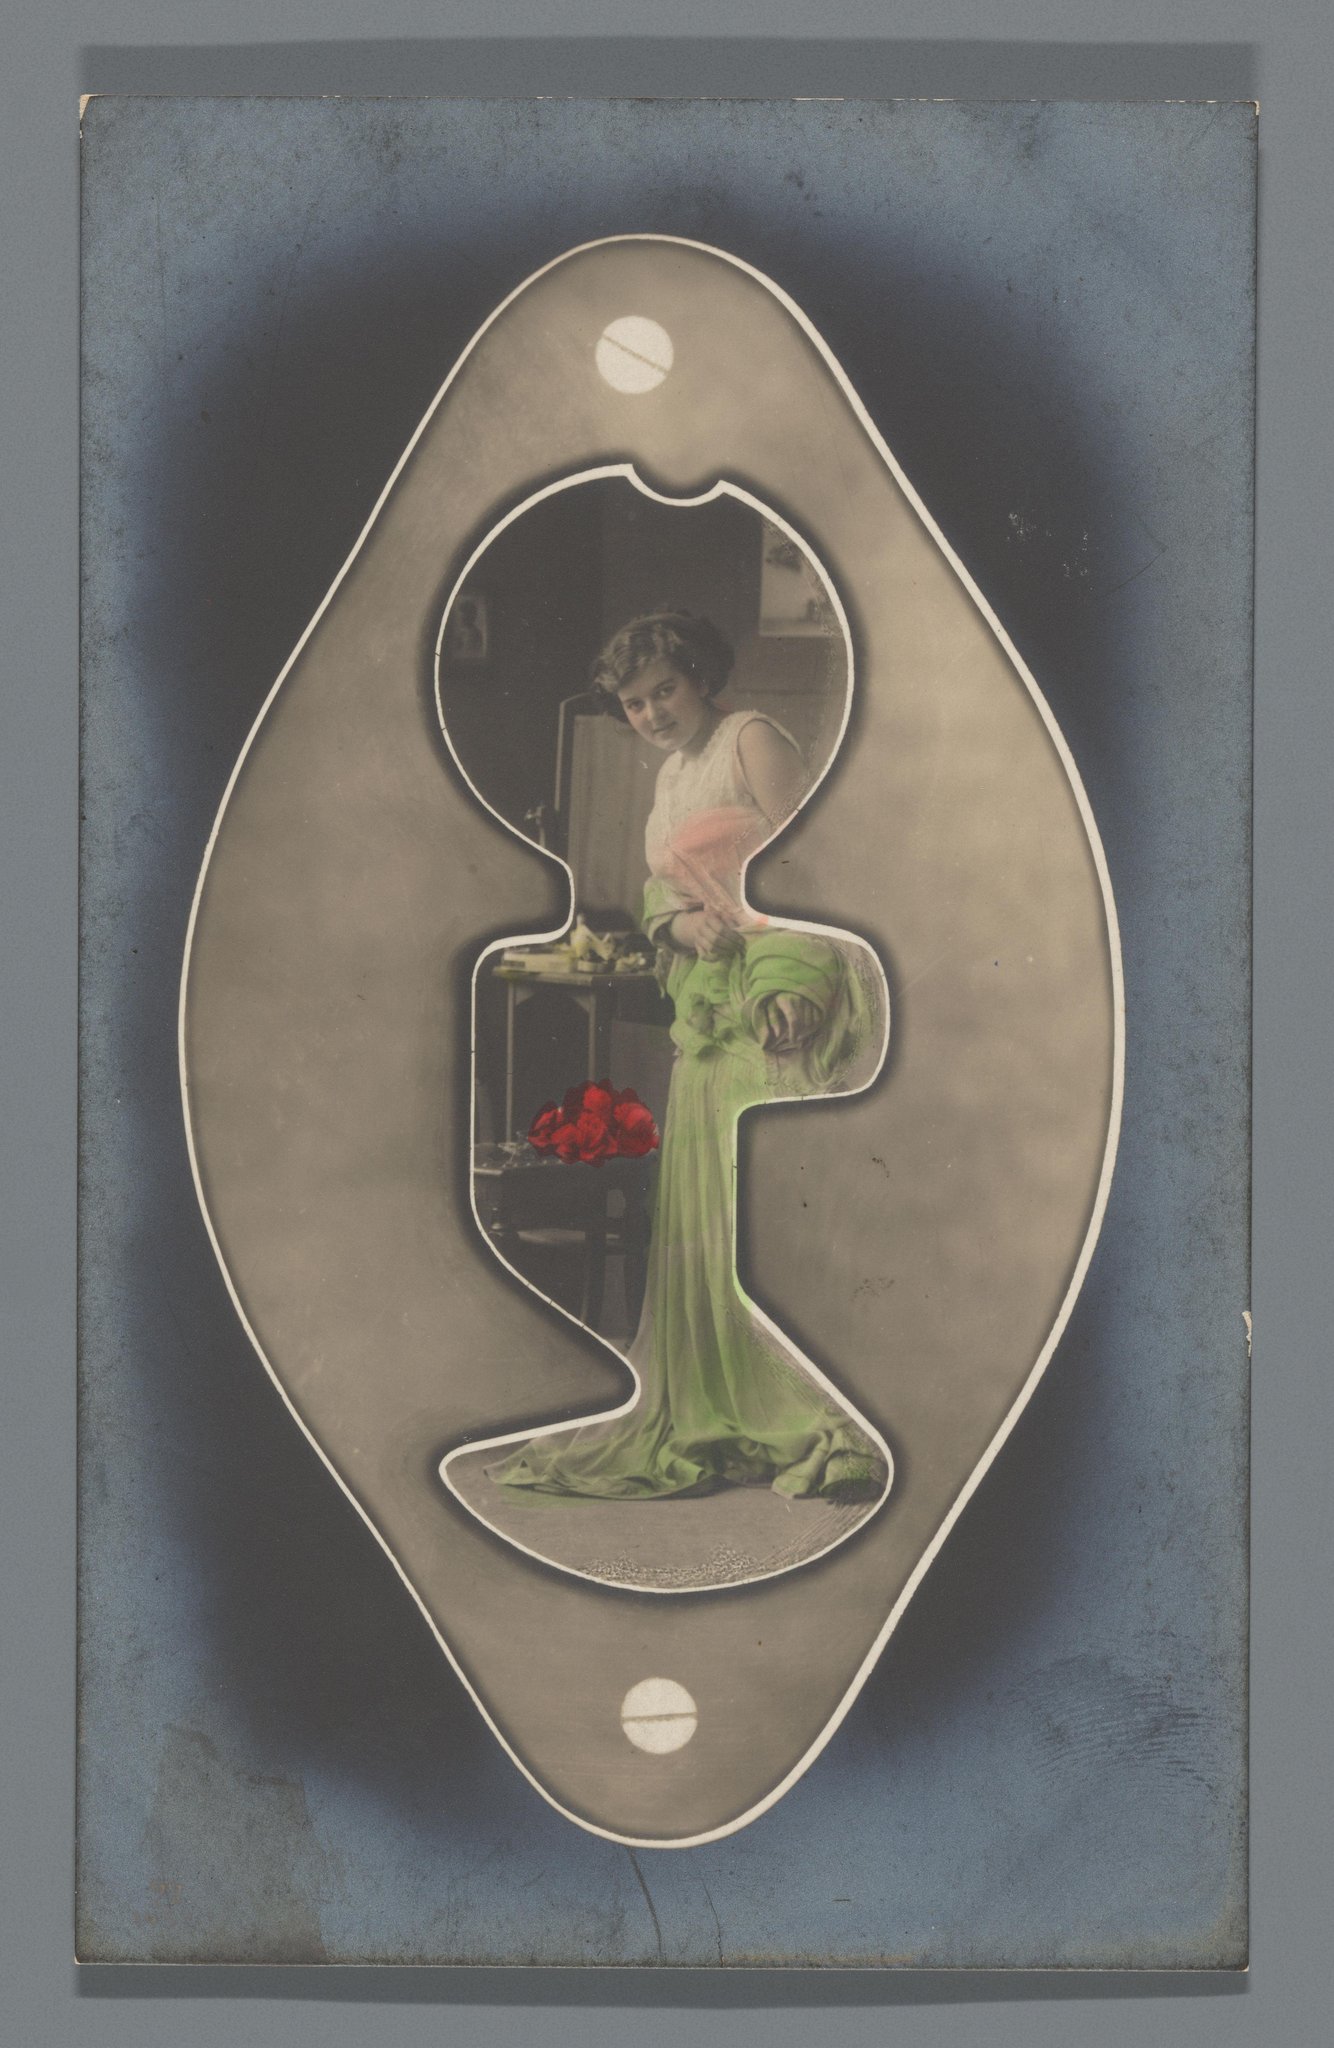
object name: ansichtkaart, prentbriefkaart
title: Vrouw die zich ontkleedt en opmaakt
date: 1920-1930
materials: paper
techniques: gelatin silver print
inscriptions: inscription: ‘GG / Co / 1457/1’, inscription: ‘P.R.A.’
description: Een van zes postkaarten/prentbriefkaarten met een voorstelling van een vrouw die zich ontkleedt en opmaakt, gezien door een sleutelgat.